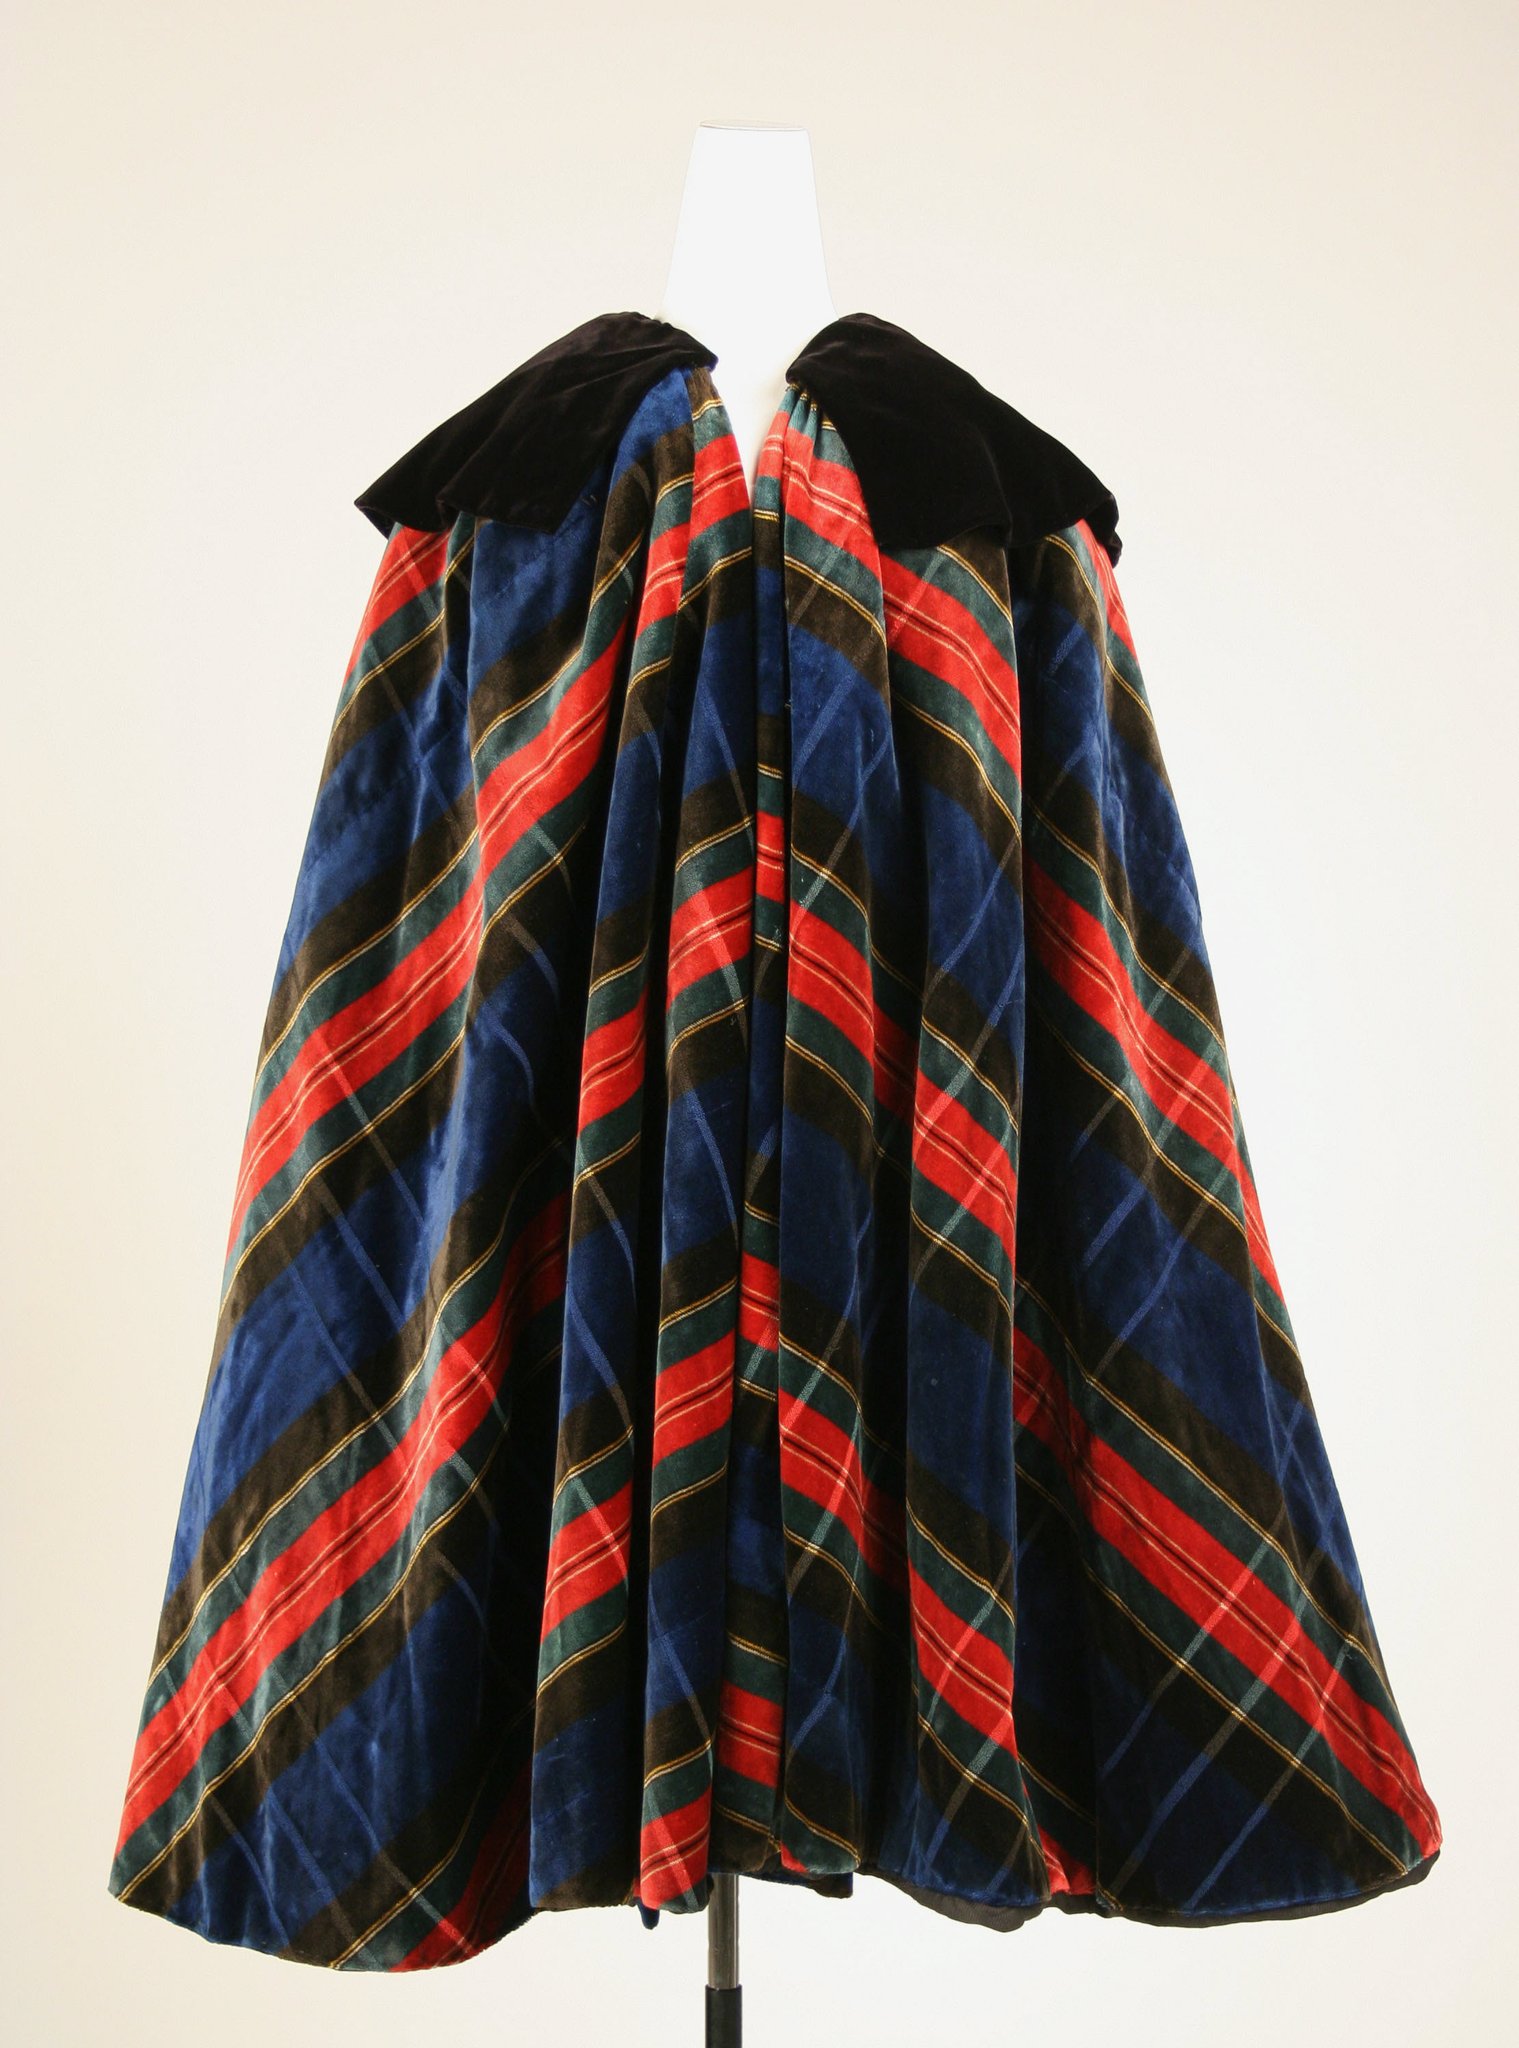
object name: pelerine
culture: american or european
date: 1834-1866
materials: cotton